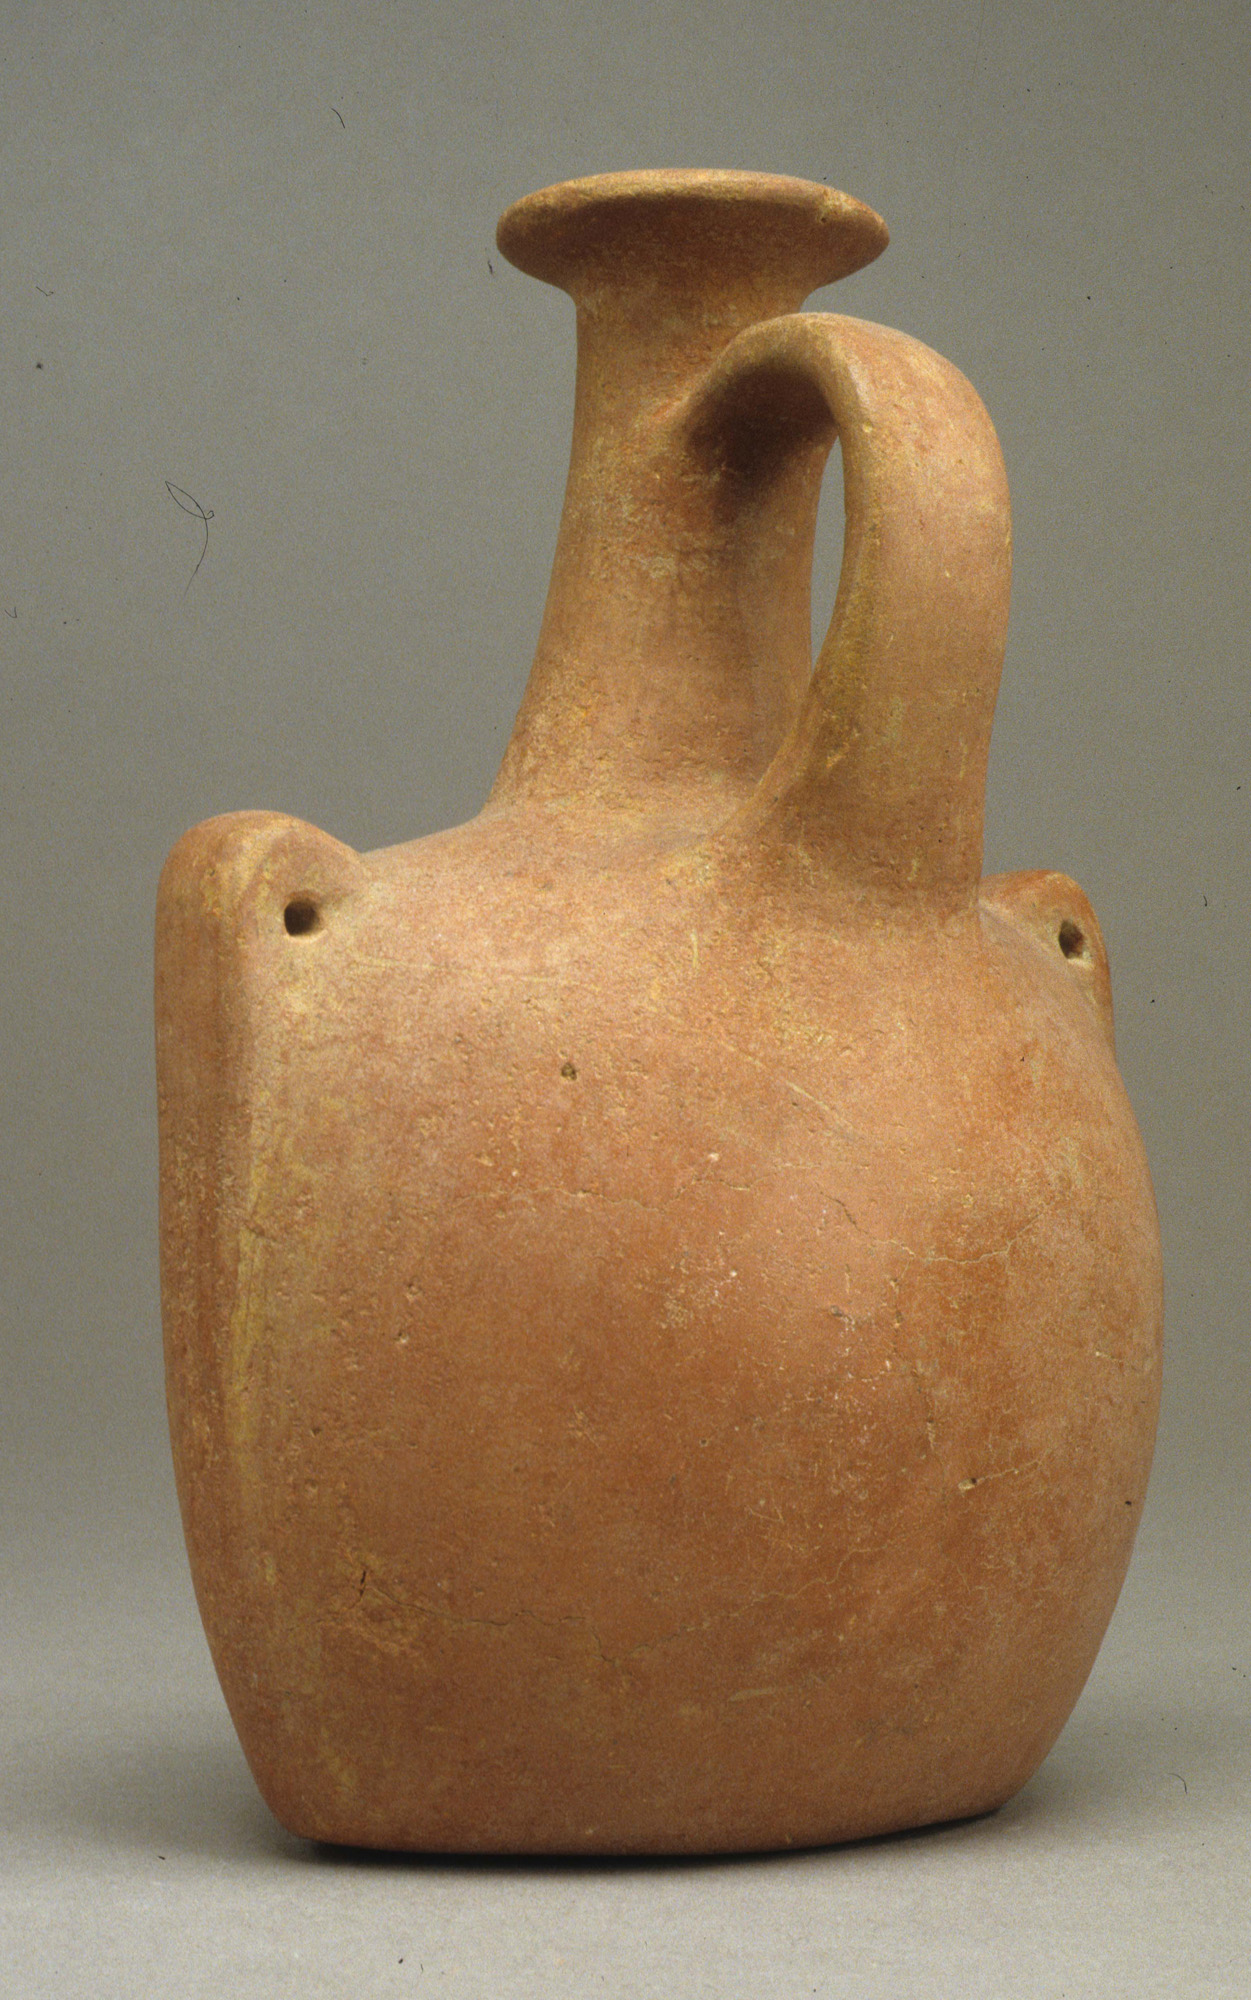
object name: vase, handle, suspension hole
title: Vase with a Handle and Two Projections with Suspension Holes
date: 1550-1391 BCE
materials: pottery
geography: egypt